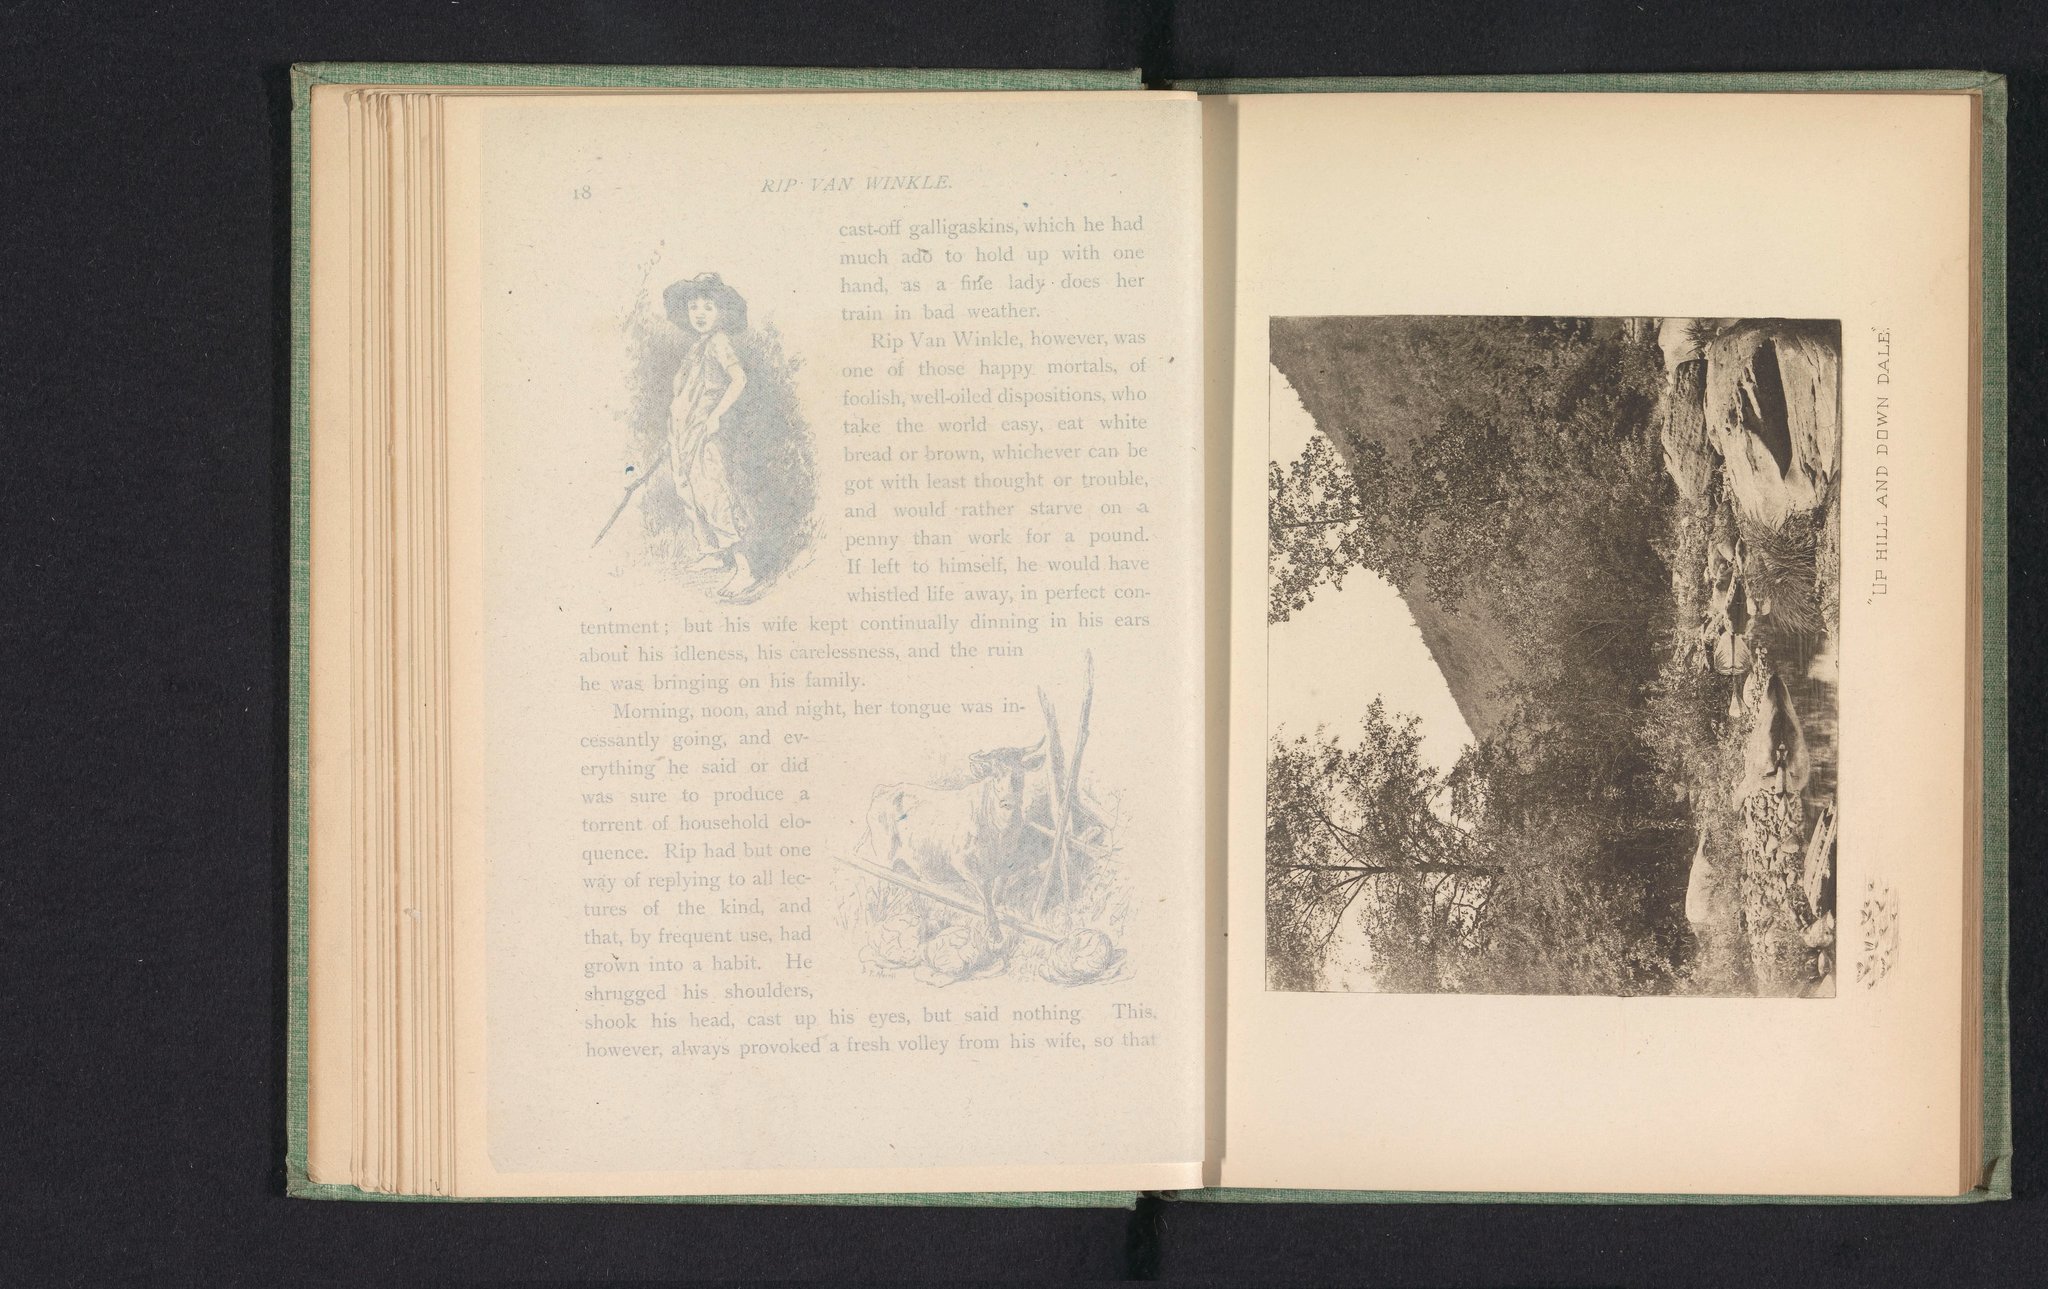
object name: photomechanical print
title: Gezicht op een heuvel en een beek in het Catskillgebergte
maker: Anonymous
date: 1884-1894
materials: paper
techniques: photoaquatint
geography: catskill mountains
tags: (high) hill, brook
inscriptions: inscription: ‘“Up hill and down dale.”’